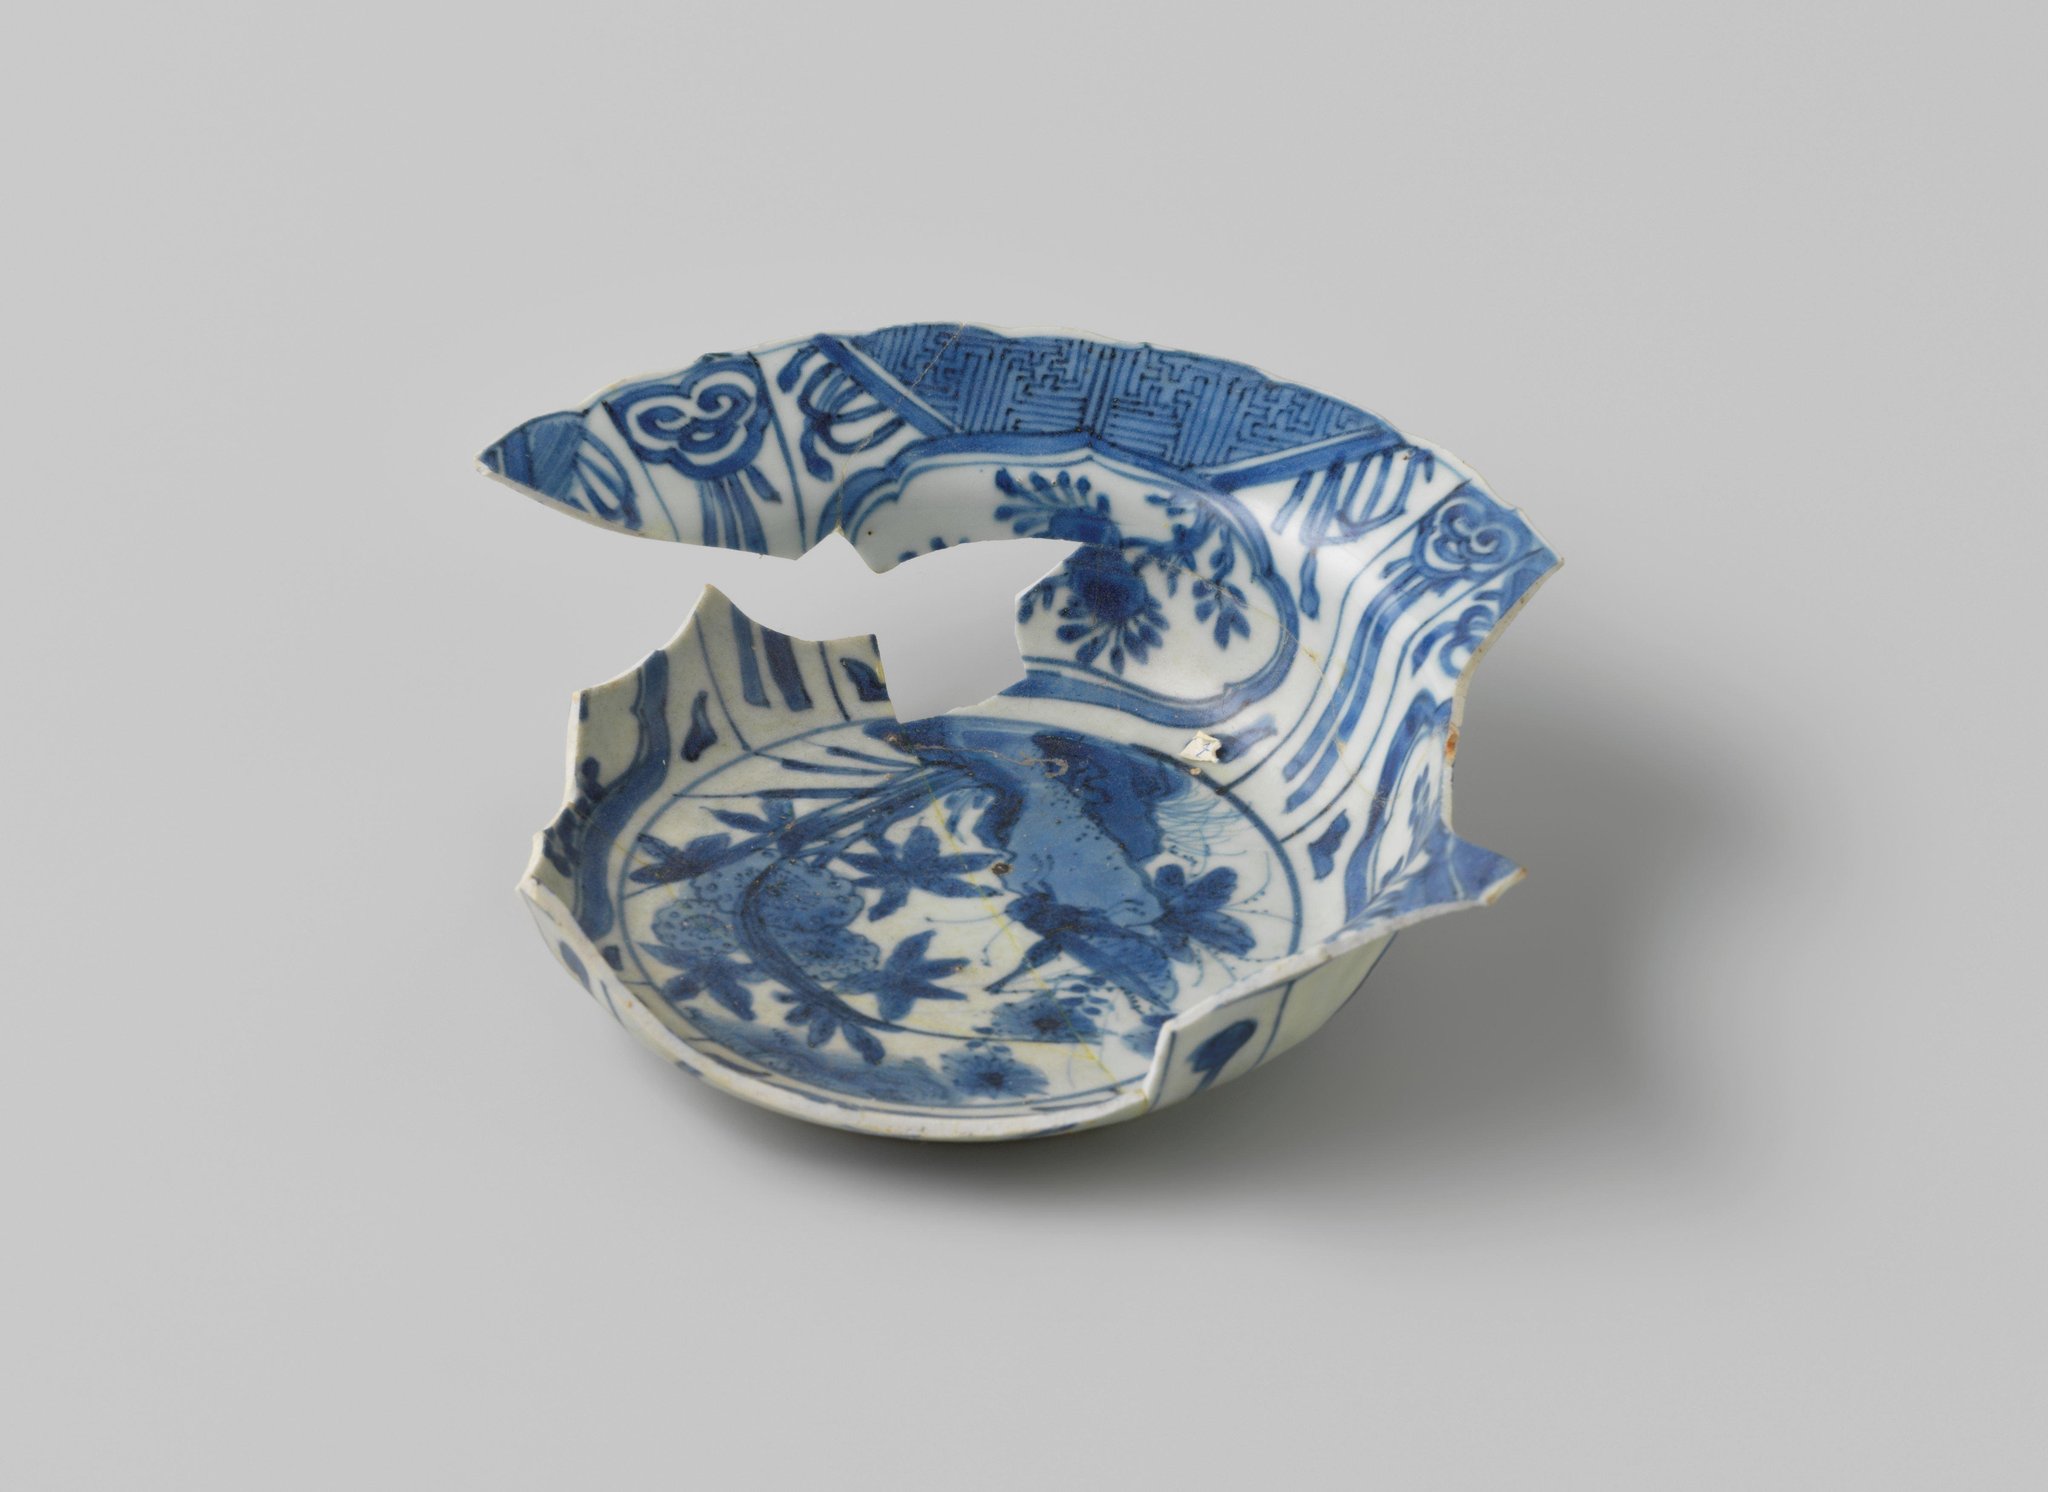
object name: plate dish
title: Fragment diep bord uit V.O.C.-schip de 'Witte Leeuw'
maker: Anonymous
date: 1613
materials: bone china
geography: jingdezhen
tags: verenigde oostindische compagnie, sint-helena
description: A bowl with a flattened rim. Taotie mask and/or borders with diaper patterns. A central decoration of a grasshopper and a rock next to flowers. Panels decorated with flowers and fruits.